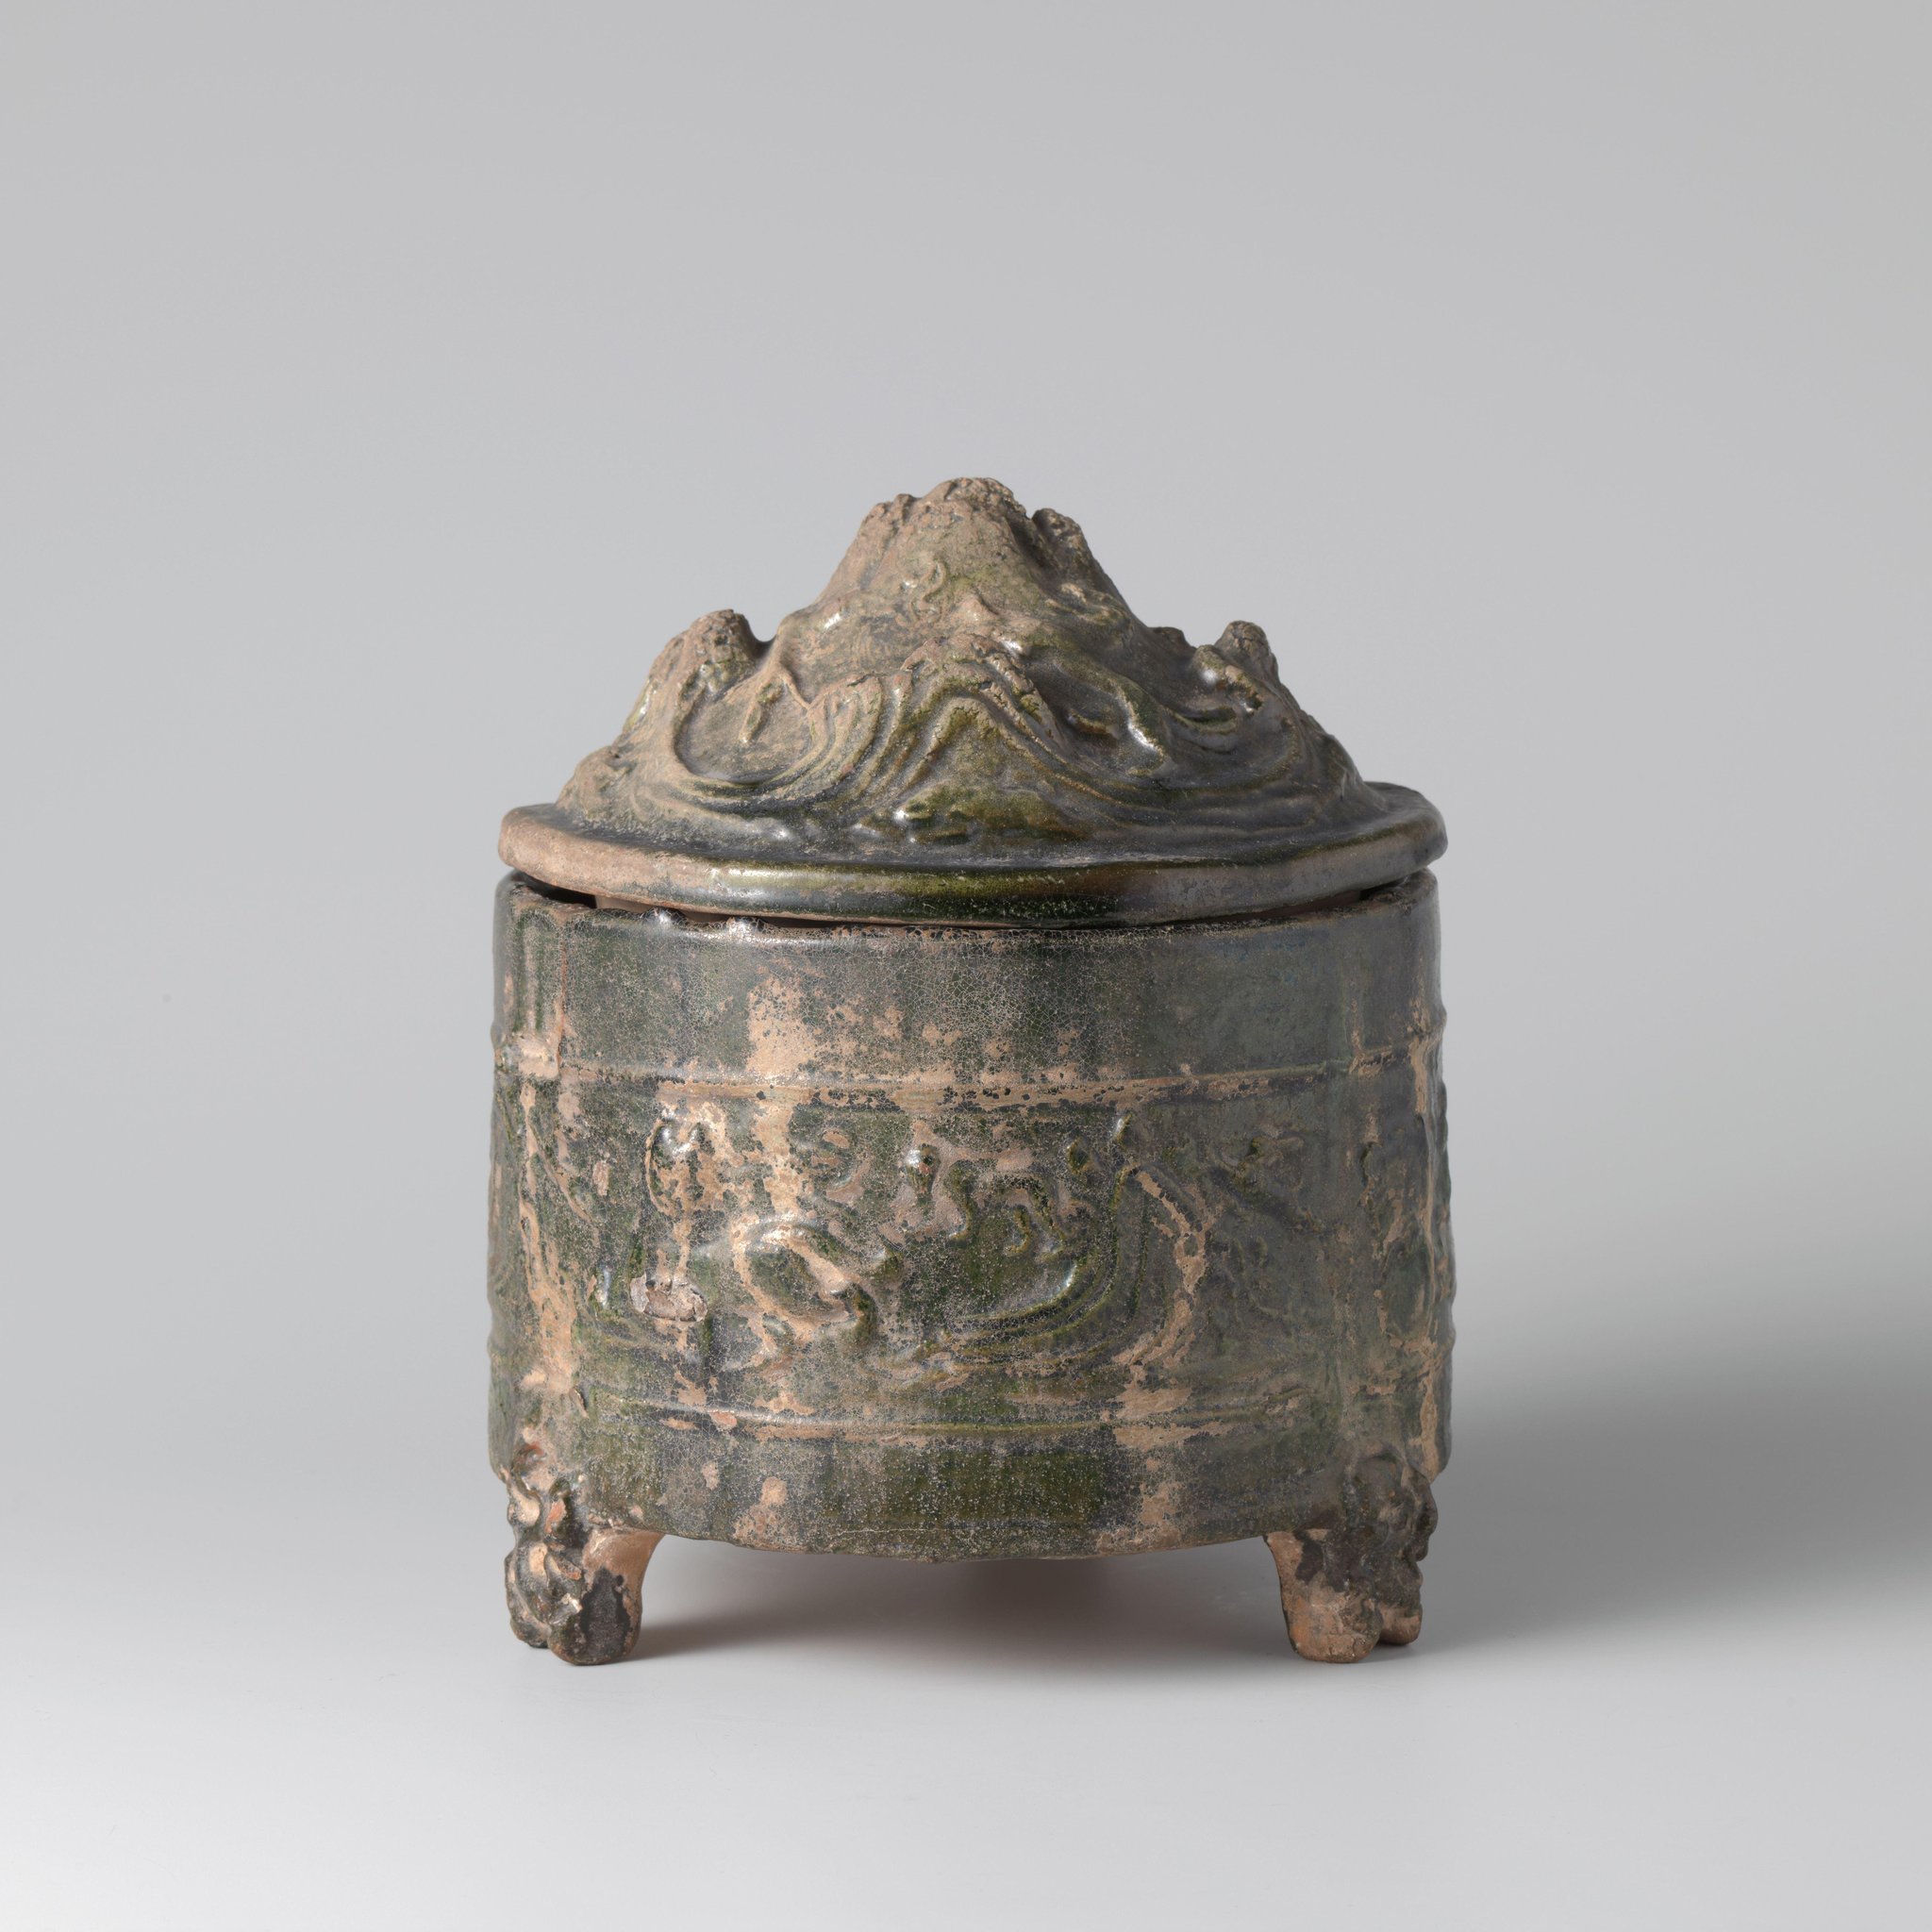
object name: lid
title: Incense burner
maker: Anonymous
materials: earthenware, glaze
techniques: firing, forming, vitrification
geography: china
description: Deksel van wierookbrander (grafgift) van aardewerk in de vorm van een berg, bedekt met een groen glazuur.